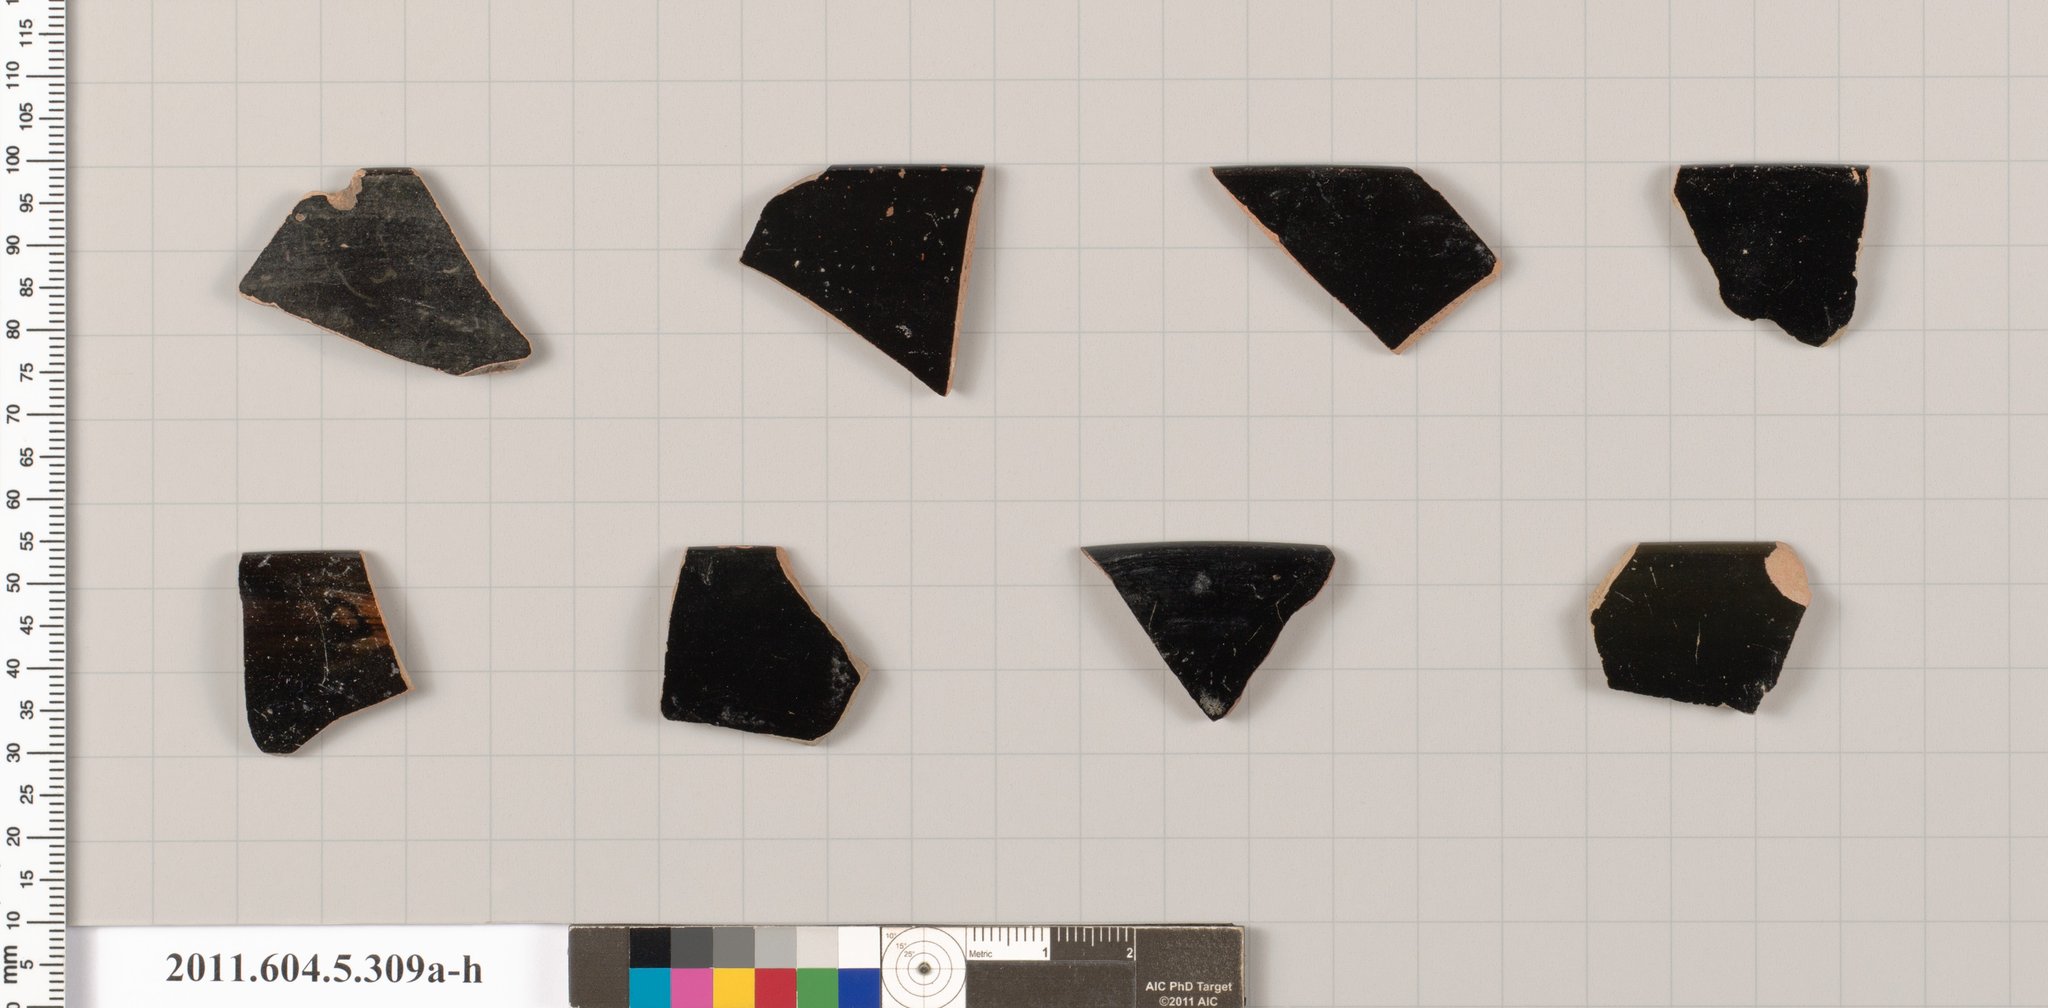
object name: kylix fragment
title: Terracotta rim fragments of kylikes (drinking cups)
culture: greek, attic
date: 600-401 BCE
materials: terracotta